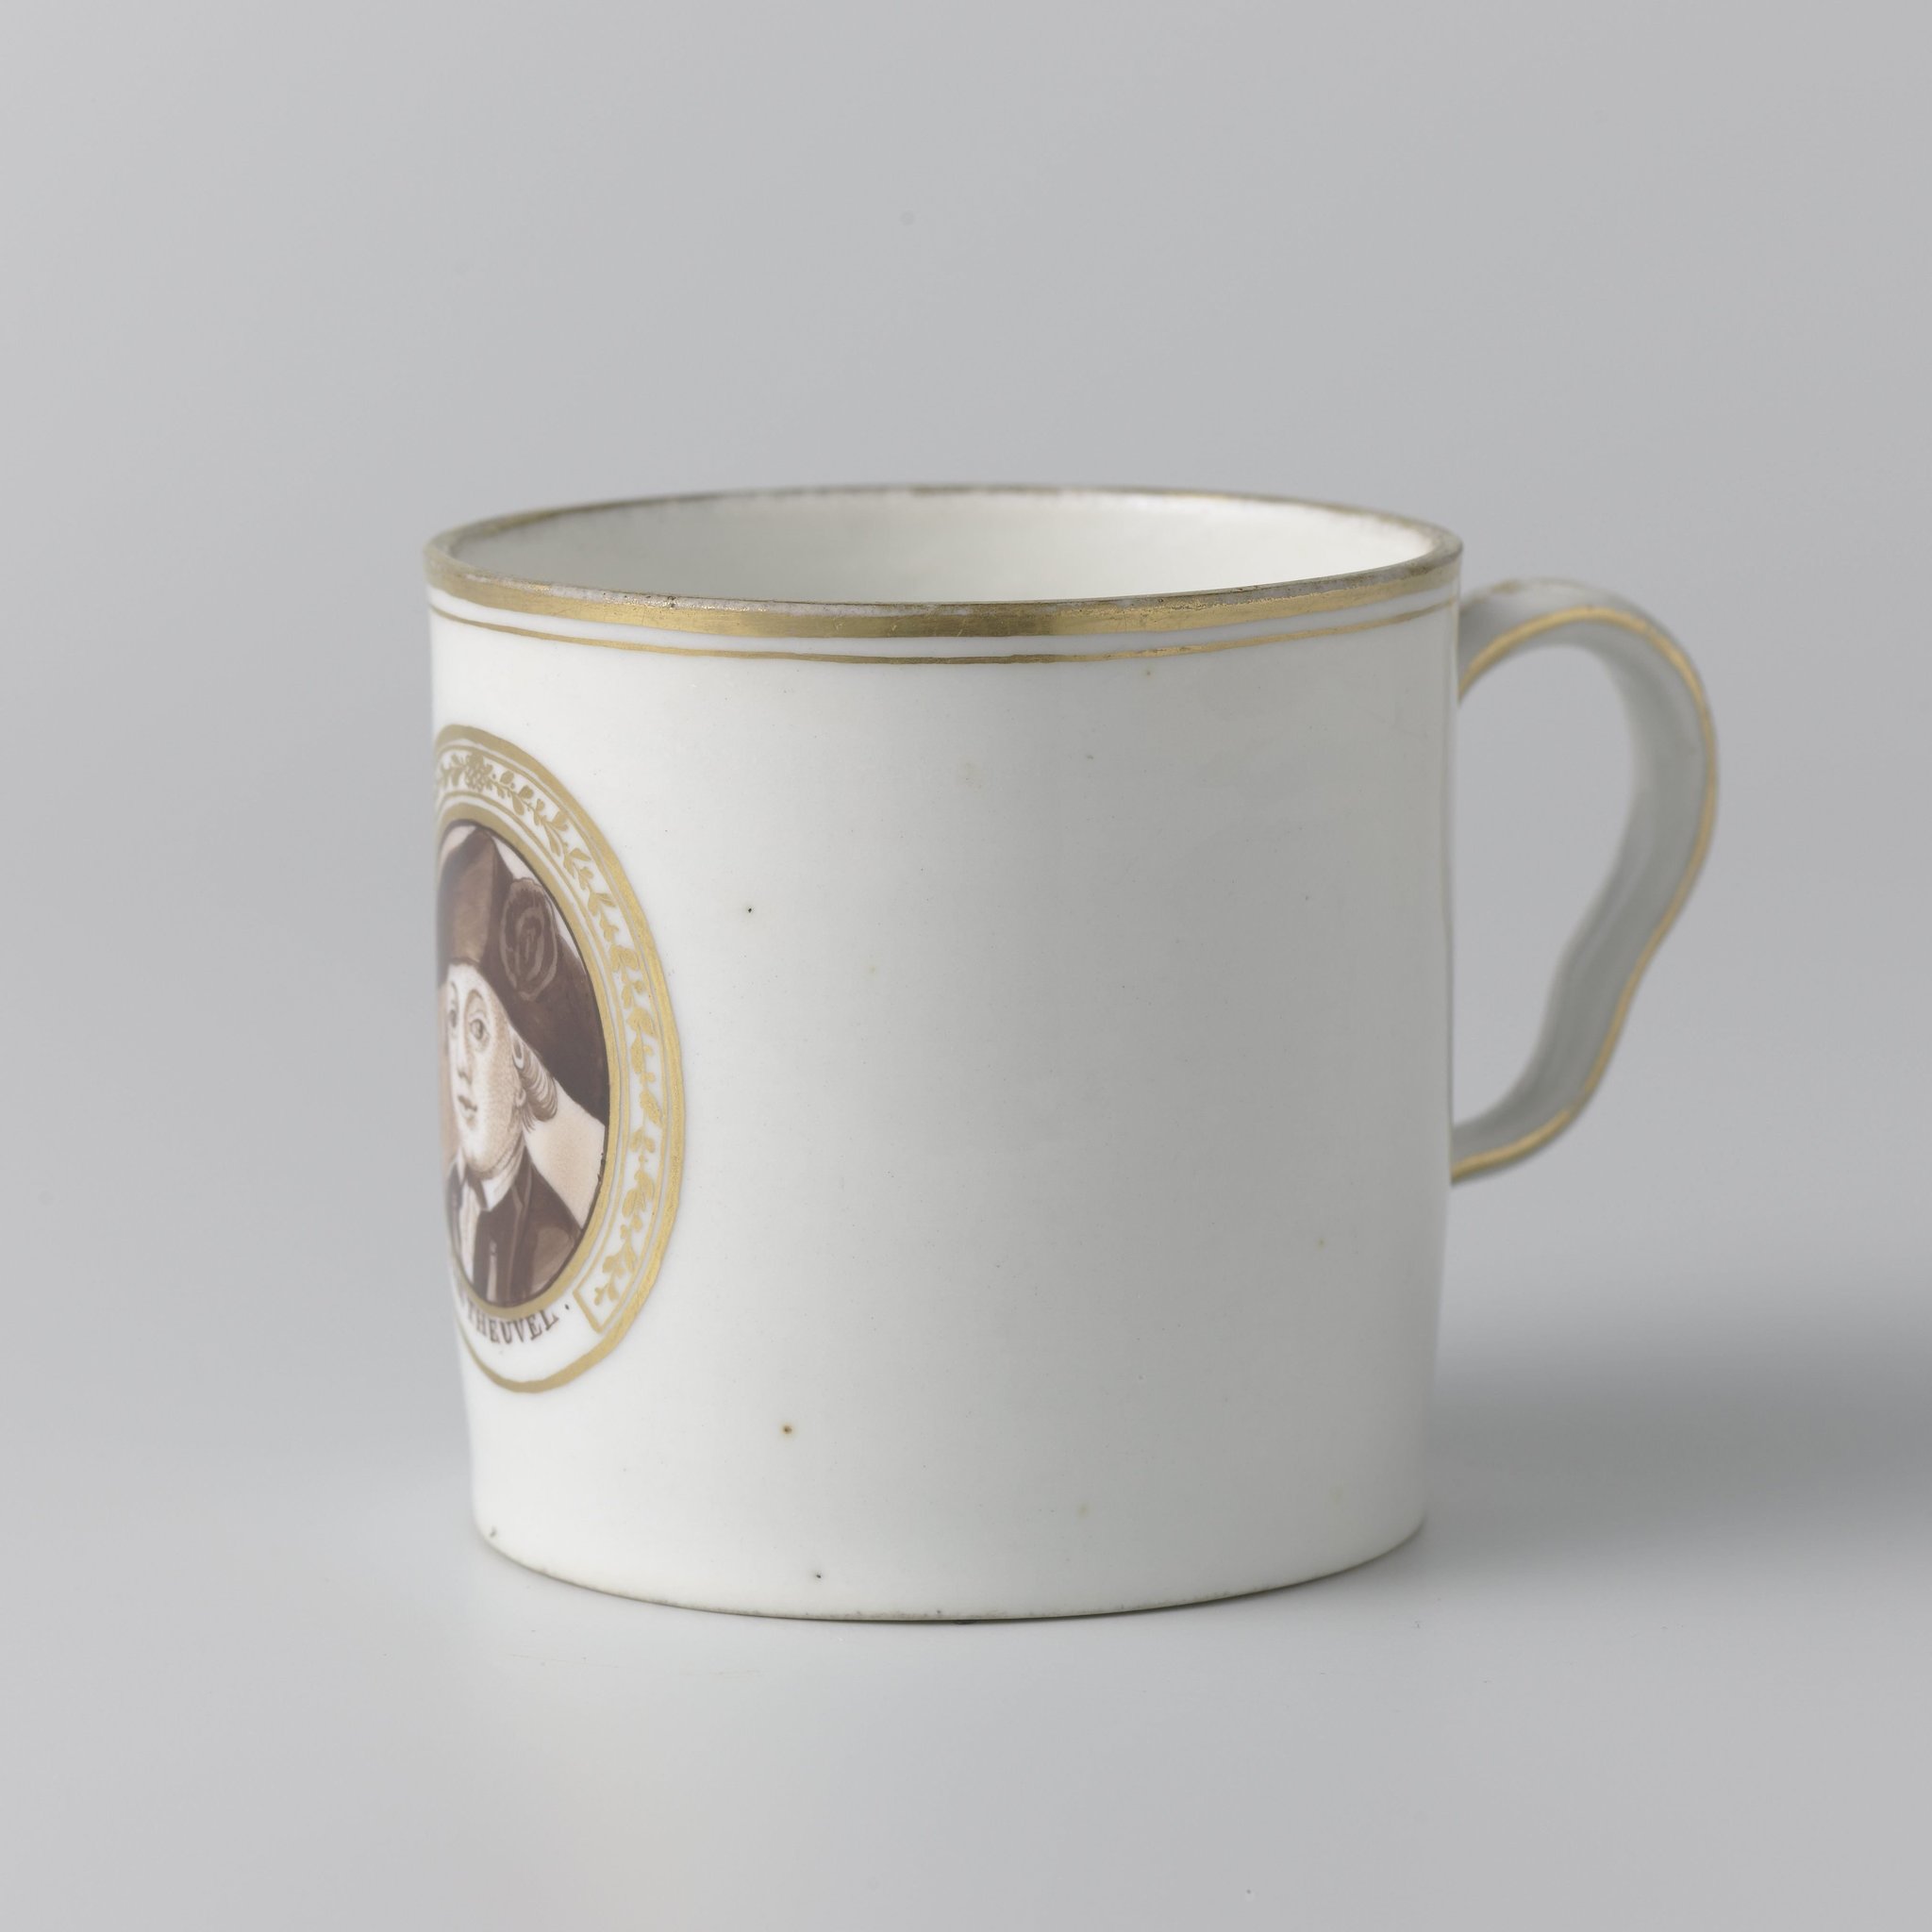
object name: service set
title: Cup with the portrait of Santheuvel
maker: Anonymous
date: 1794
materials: glaze, gold, paint, porcelain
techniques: firing, forming, gilding, turning, vitrification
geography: schwarzburg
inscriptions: mark: ‘103-N/ 5’, inscription: ‘SANTHEUVEL.’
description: Kop van porselein, beschilderd op het glazuur in sepia en goud. Op de buitenwand een medaillon met een portret. Een band met een bladrank en het opschrift 'SANTHEUVEL.' om het medaillon. Gouden rand en een bladrank op het oor. Gemerkt op de onderzijde met 103-N en 5.